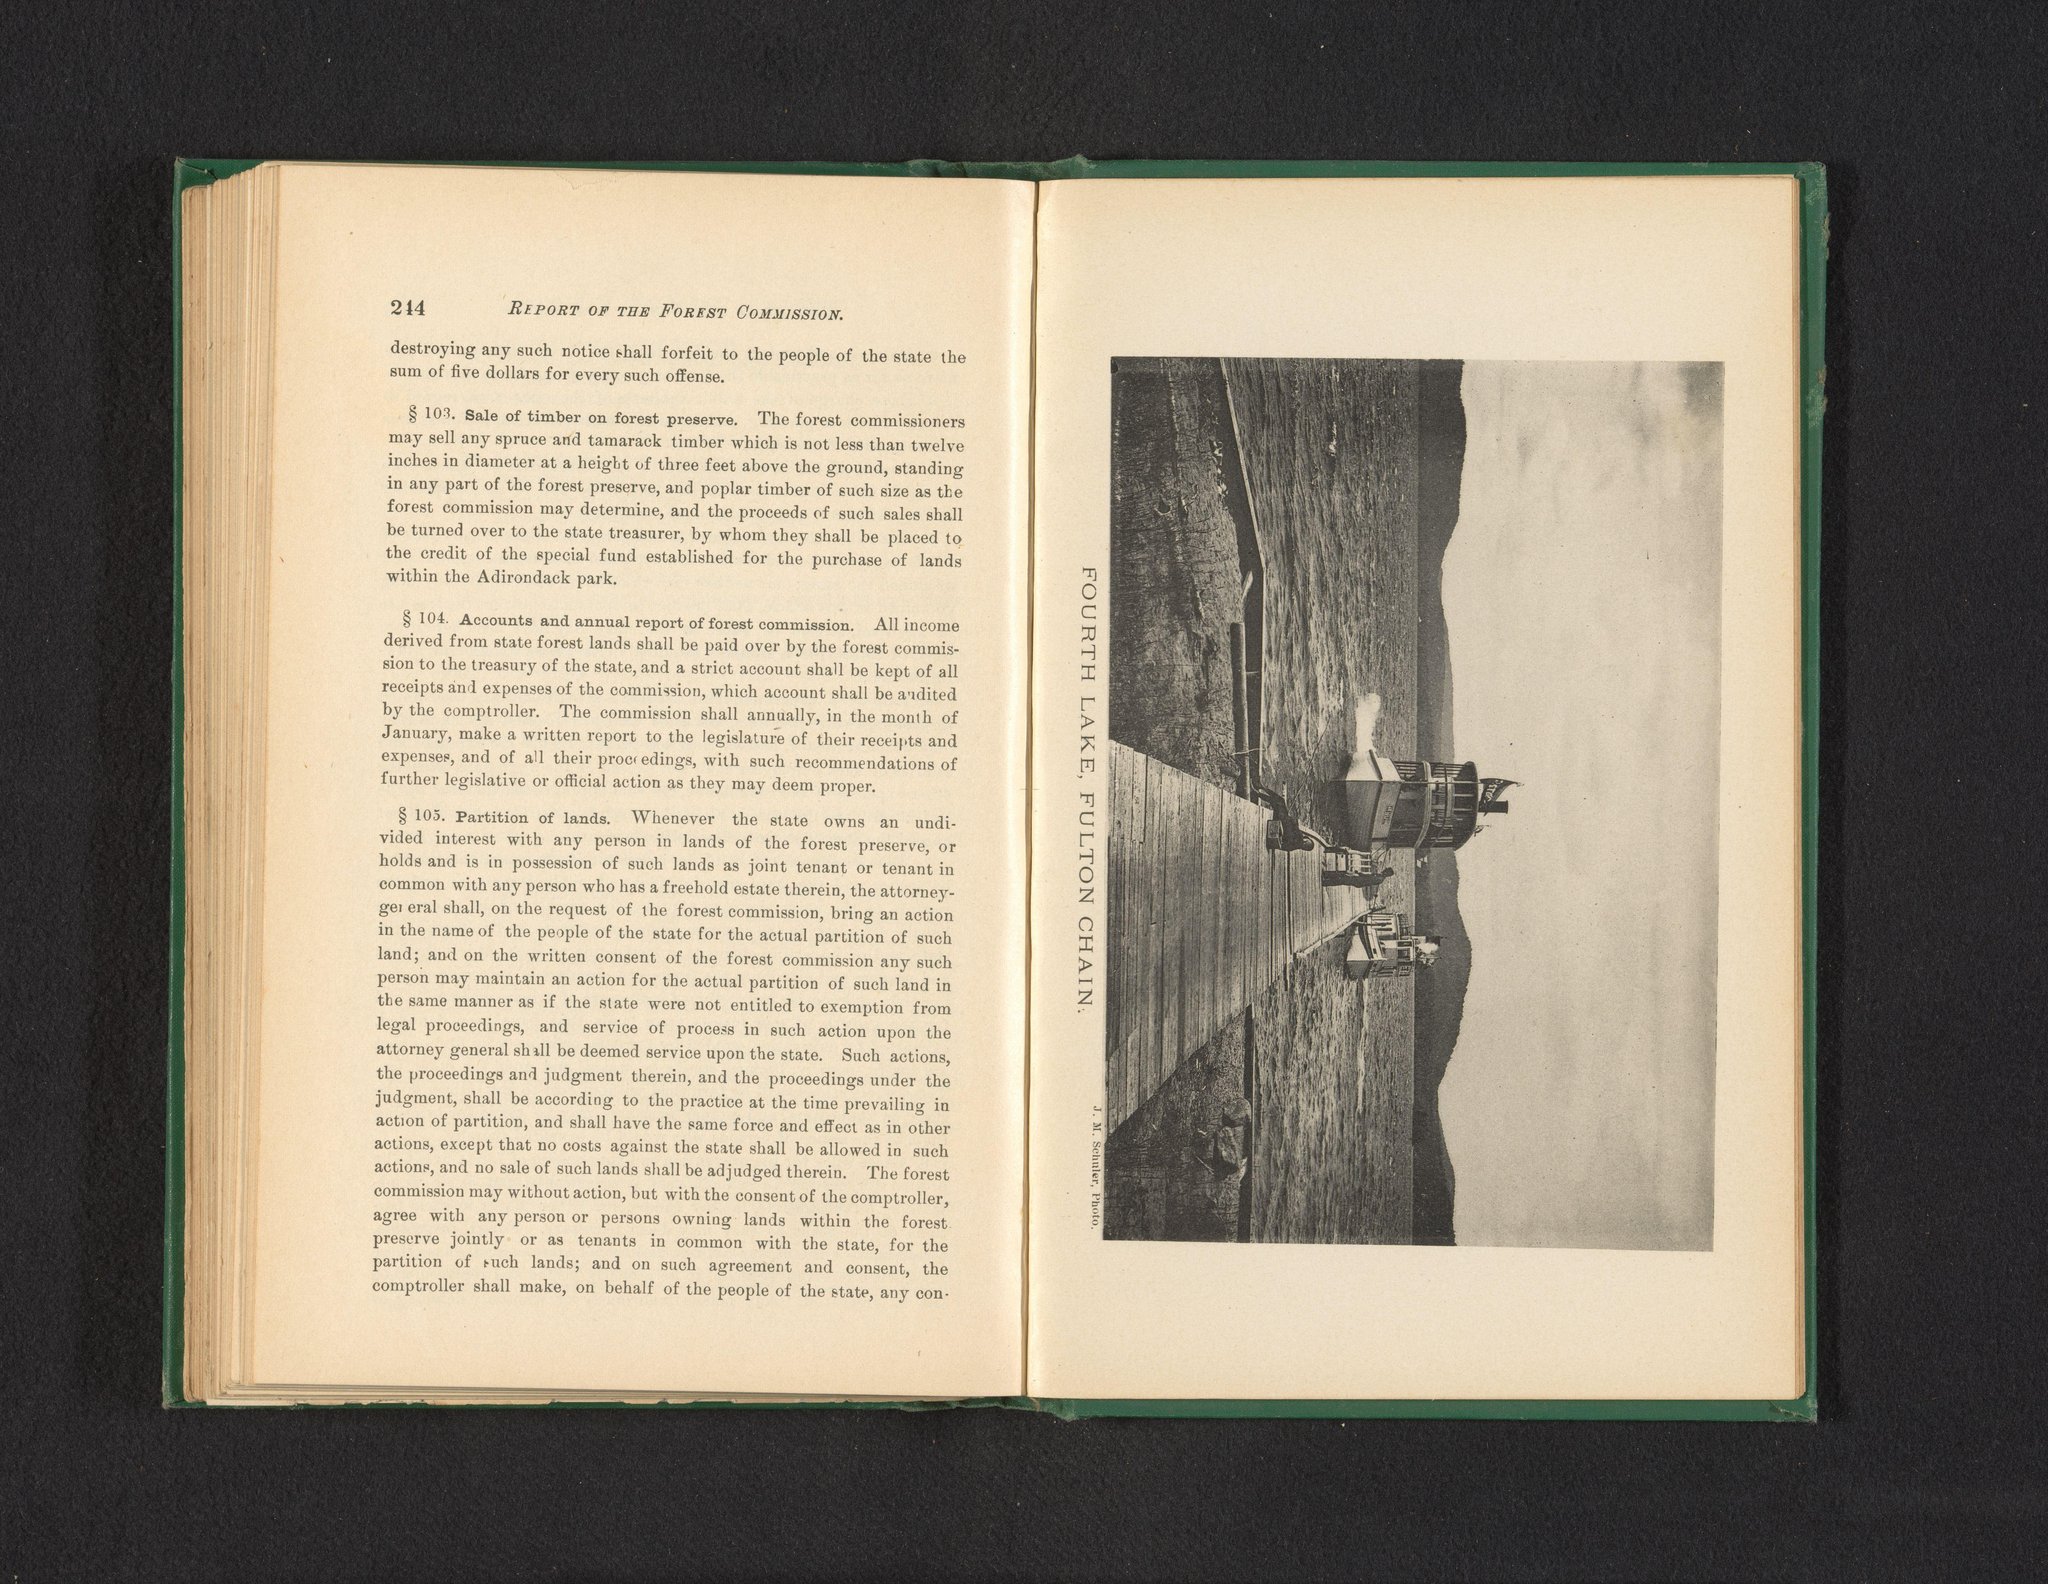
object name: photomechanical print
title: Fourth Lake, Fulton Chain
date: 1894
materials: paper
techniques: photograph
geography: new york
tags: flood